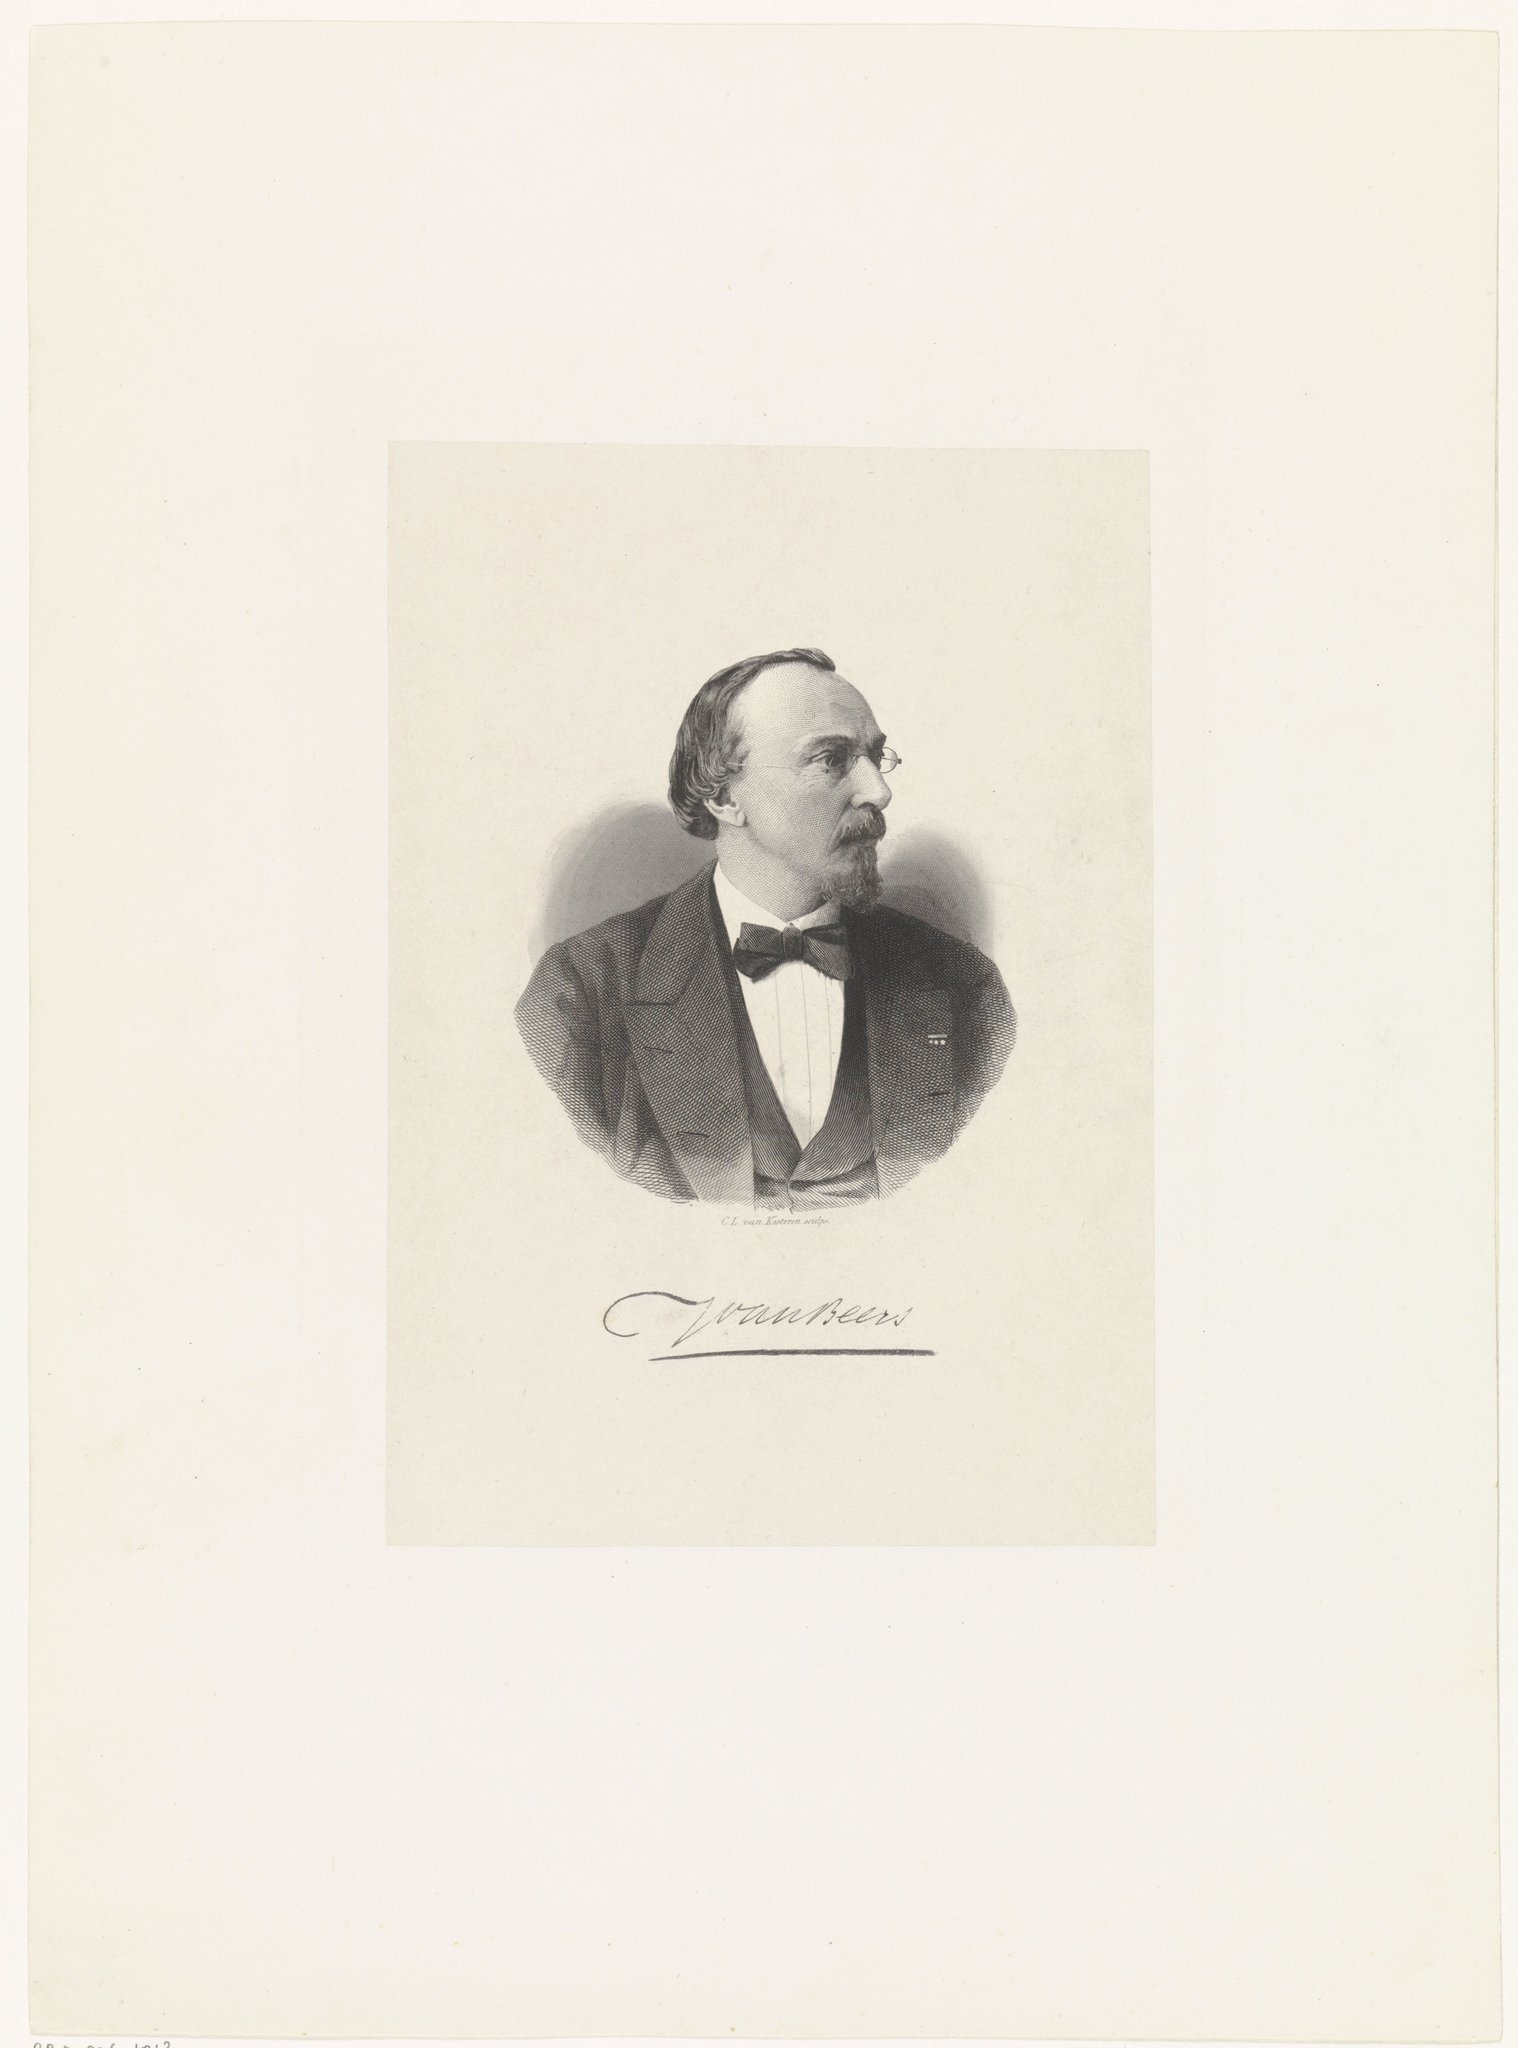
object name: print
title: Portret van Jan van Beers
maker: christiaan lodewijk van kesteren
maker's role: print maker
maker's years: 1832-1897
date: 1873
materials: paper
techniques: engraving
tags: lierre, painter, print maker, jan van beers (schilder)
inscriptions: collector's mark: Lugt 2228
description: Portretbuste met het hoofd naar rechts, van de dichter en leraar Jan van Beers. Van Beers draagt een bril en een strik.